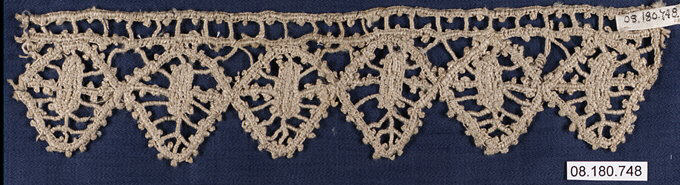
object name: fragment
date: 1801-1900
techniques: lace